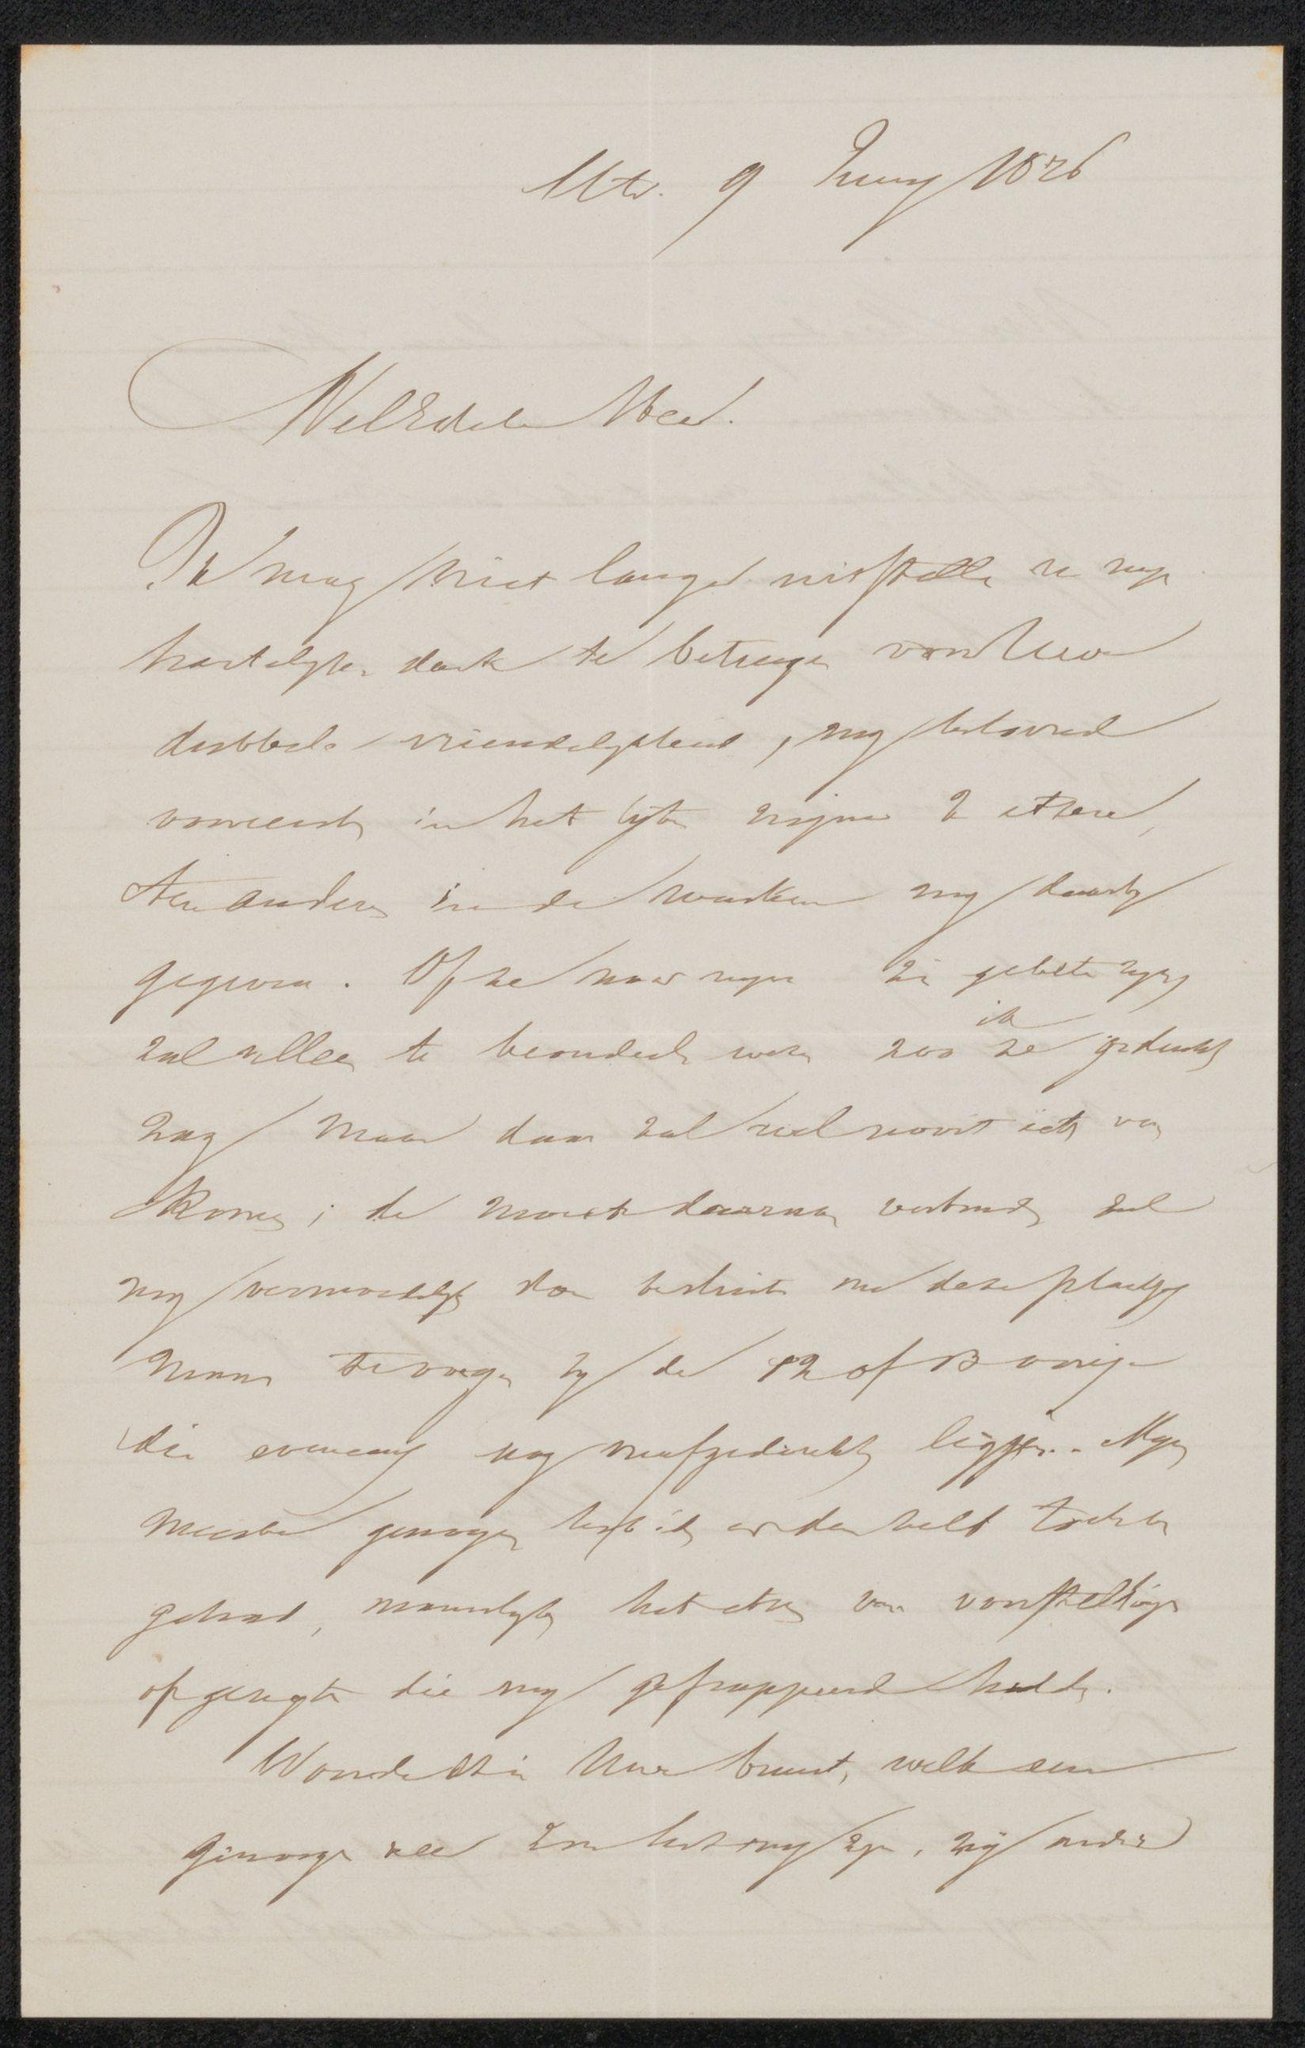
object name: letter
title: Brief aan anoniem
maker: louis charles hora siccama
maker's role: draughtsman, print maker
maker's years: 1807-1880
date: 1876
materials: ink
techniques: pen, writing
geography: utrecht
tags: the graphic arts